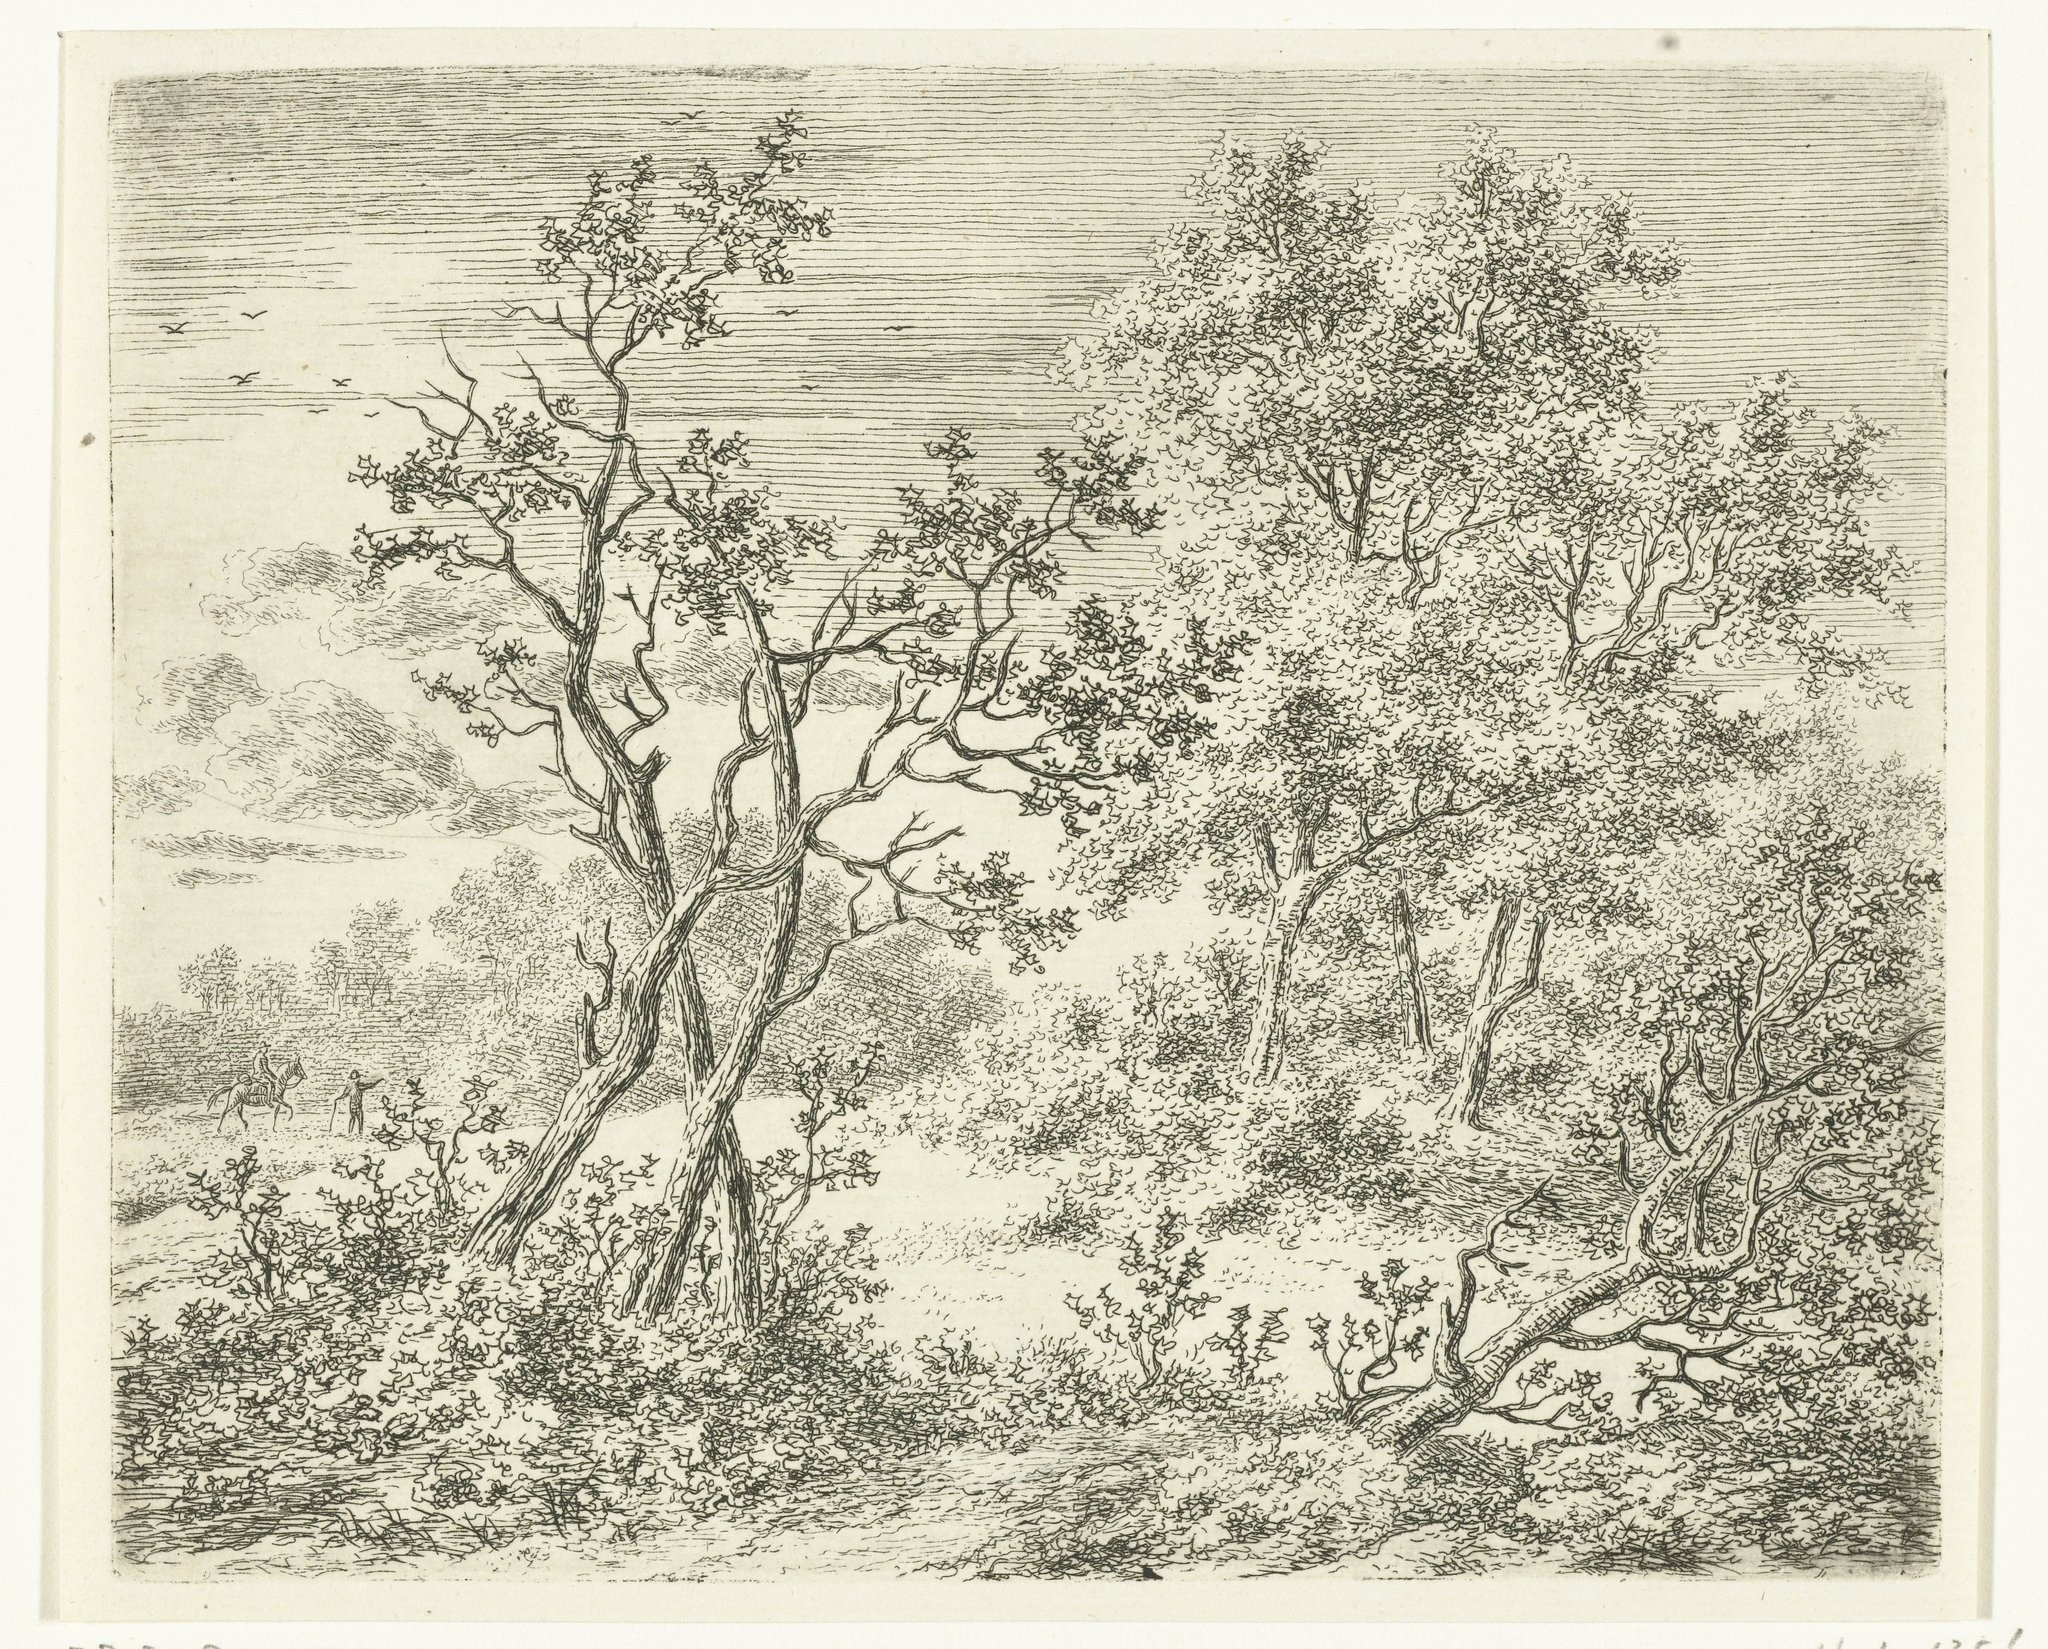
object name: print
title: Boomrijk landschap met ruiter en voetganger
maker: ernst willem jan bagelaar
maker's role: draughtsman, print maker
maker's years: 1775-1837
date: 1798-1837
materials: paper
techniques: etching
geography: netherlands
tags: forest, wood (+ landscape with figures, staffage)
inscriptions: collector's mark: Lugt 2228